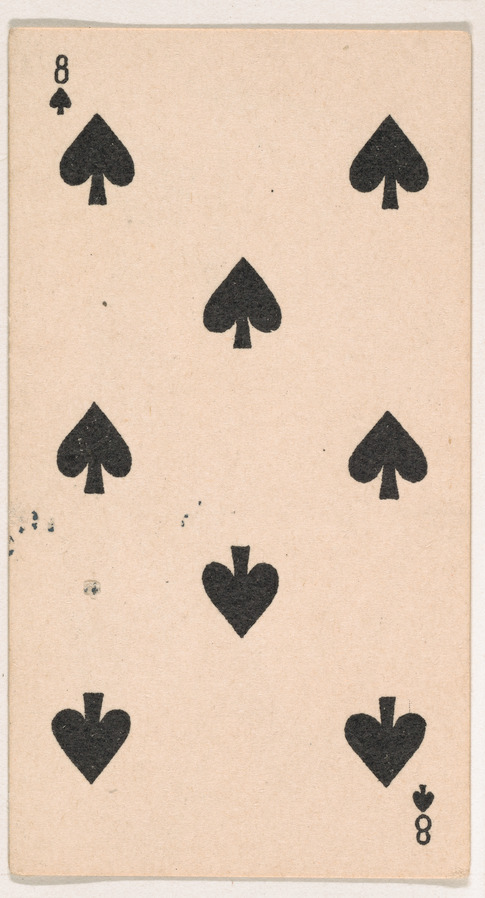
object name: print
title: Eight of Spades, from the Transparent Playing Cards series (N220) issued by Kinney Bros.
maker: kinney brothers tobacco company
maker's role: publisher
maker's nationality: american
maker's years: 1869-2011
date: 1888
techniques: color lithograph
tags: playing cards